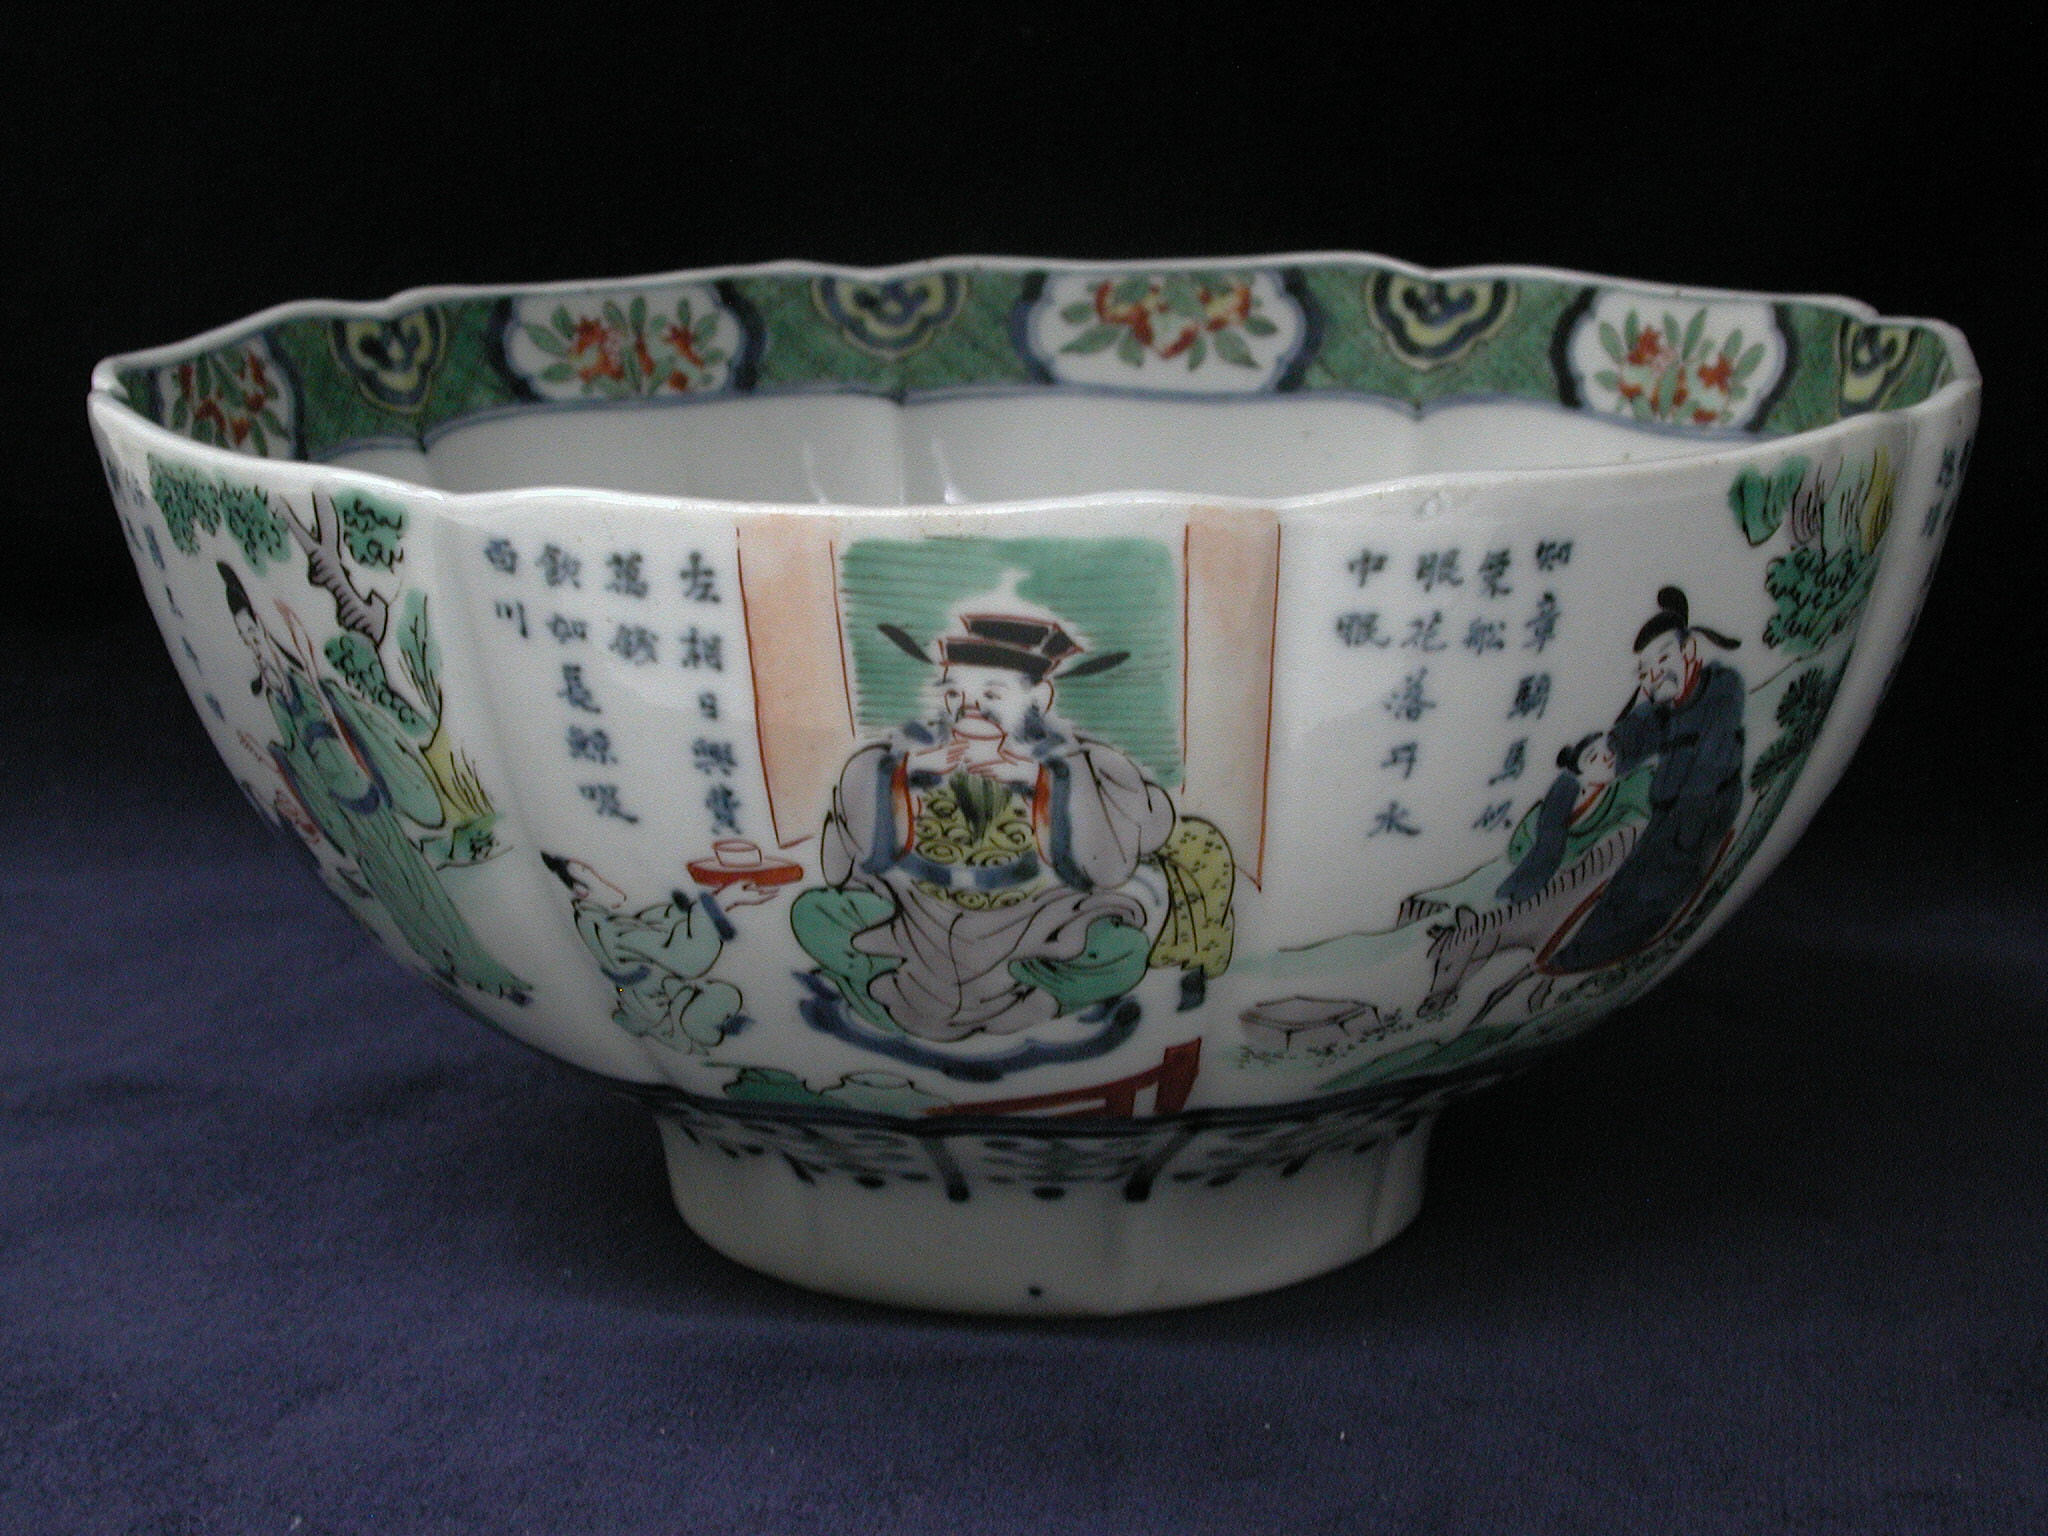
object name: bowl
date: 1801-1900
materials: hard paste porcelain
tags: men